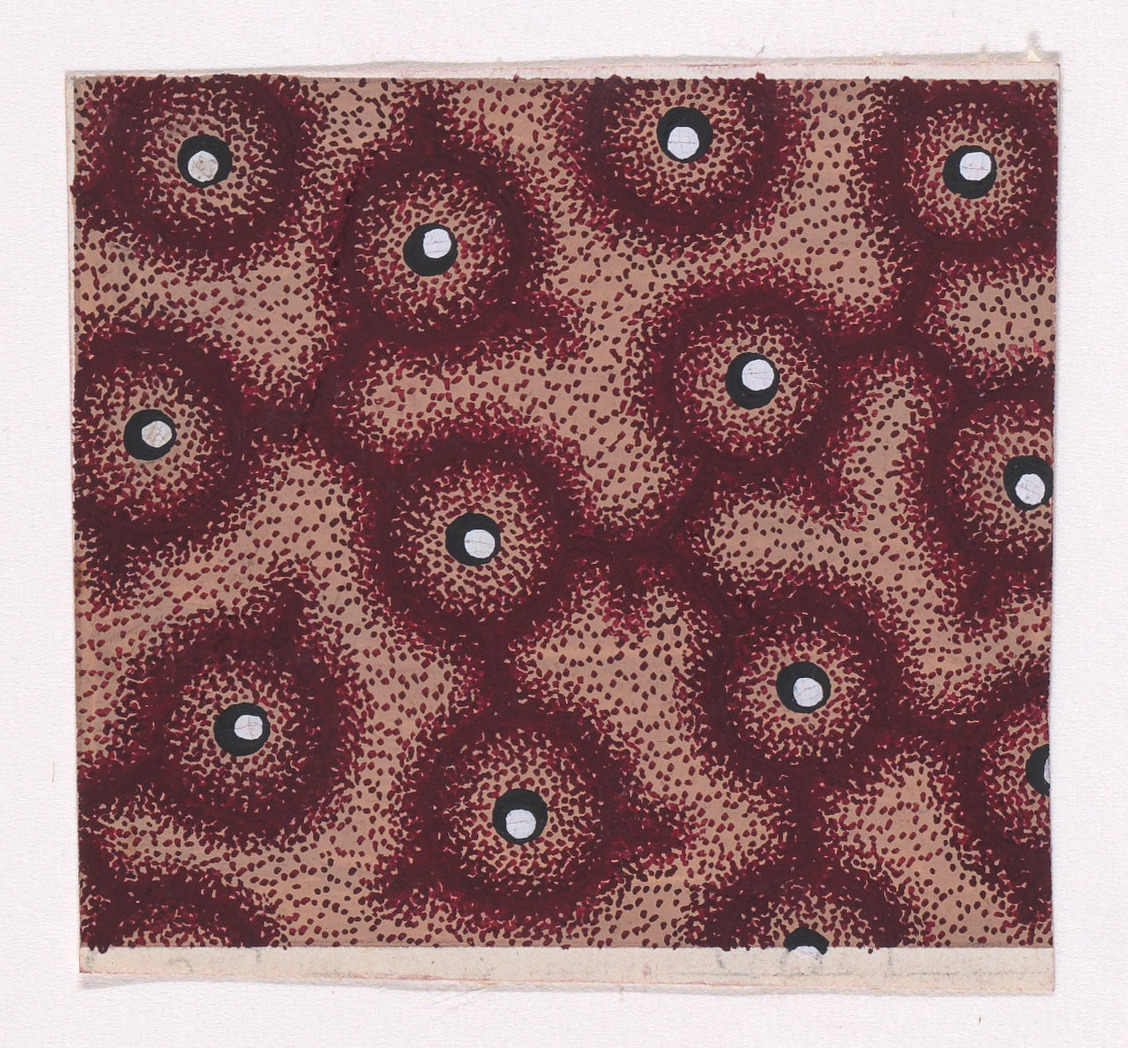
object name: drawing ornament architecture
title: Textile Design with a Network of Circles with Pearls in the Middle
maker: anonymous, alsatian, 19th century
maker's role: artist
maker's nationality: alsatian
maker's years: 1800-1900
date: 1840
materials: gouache